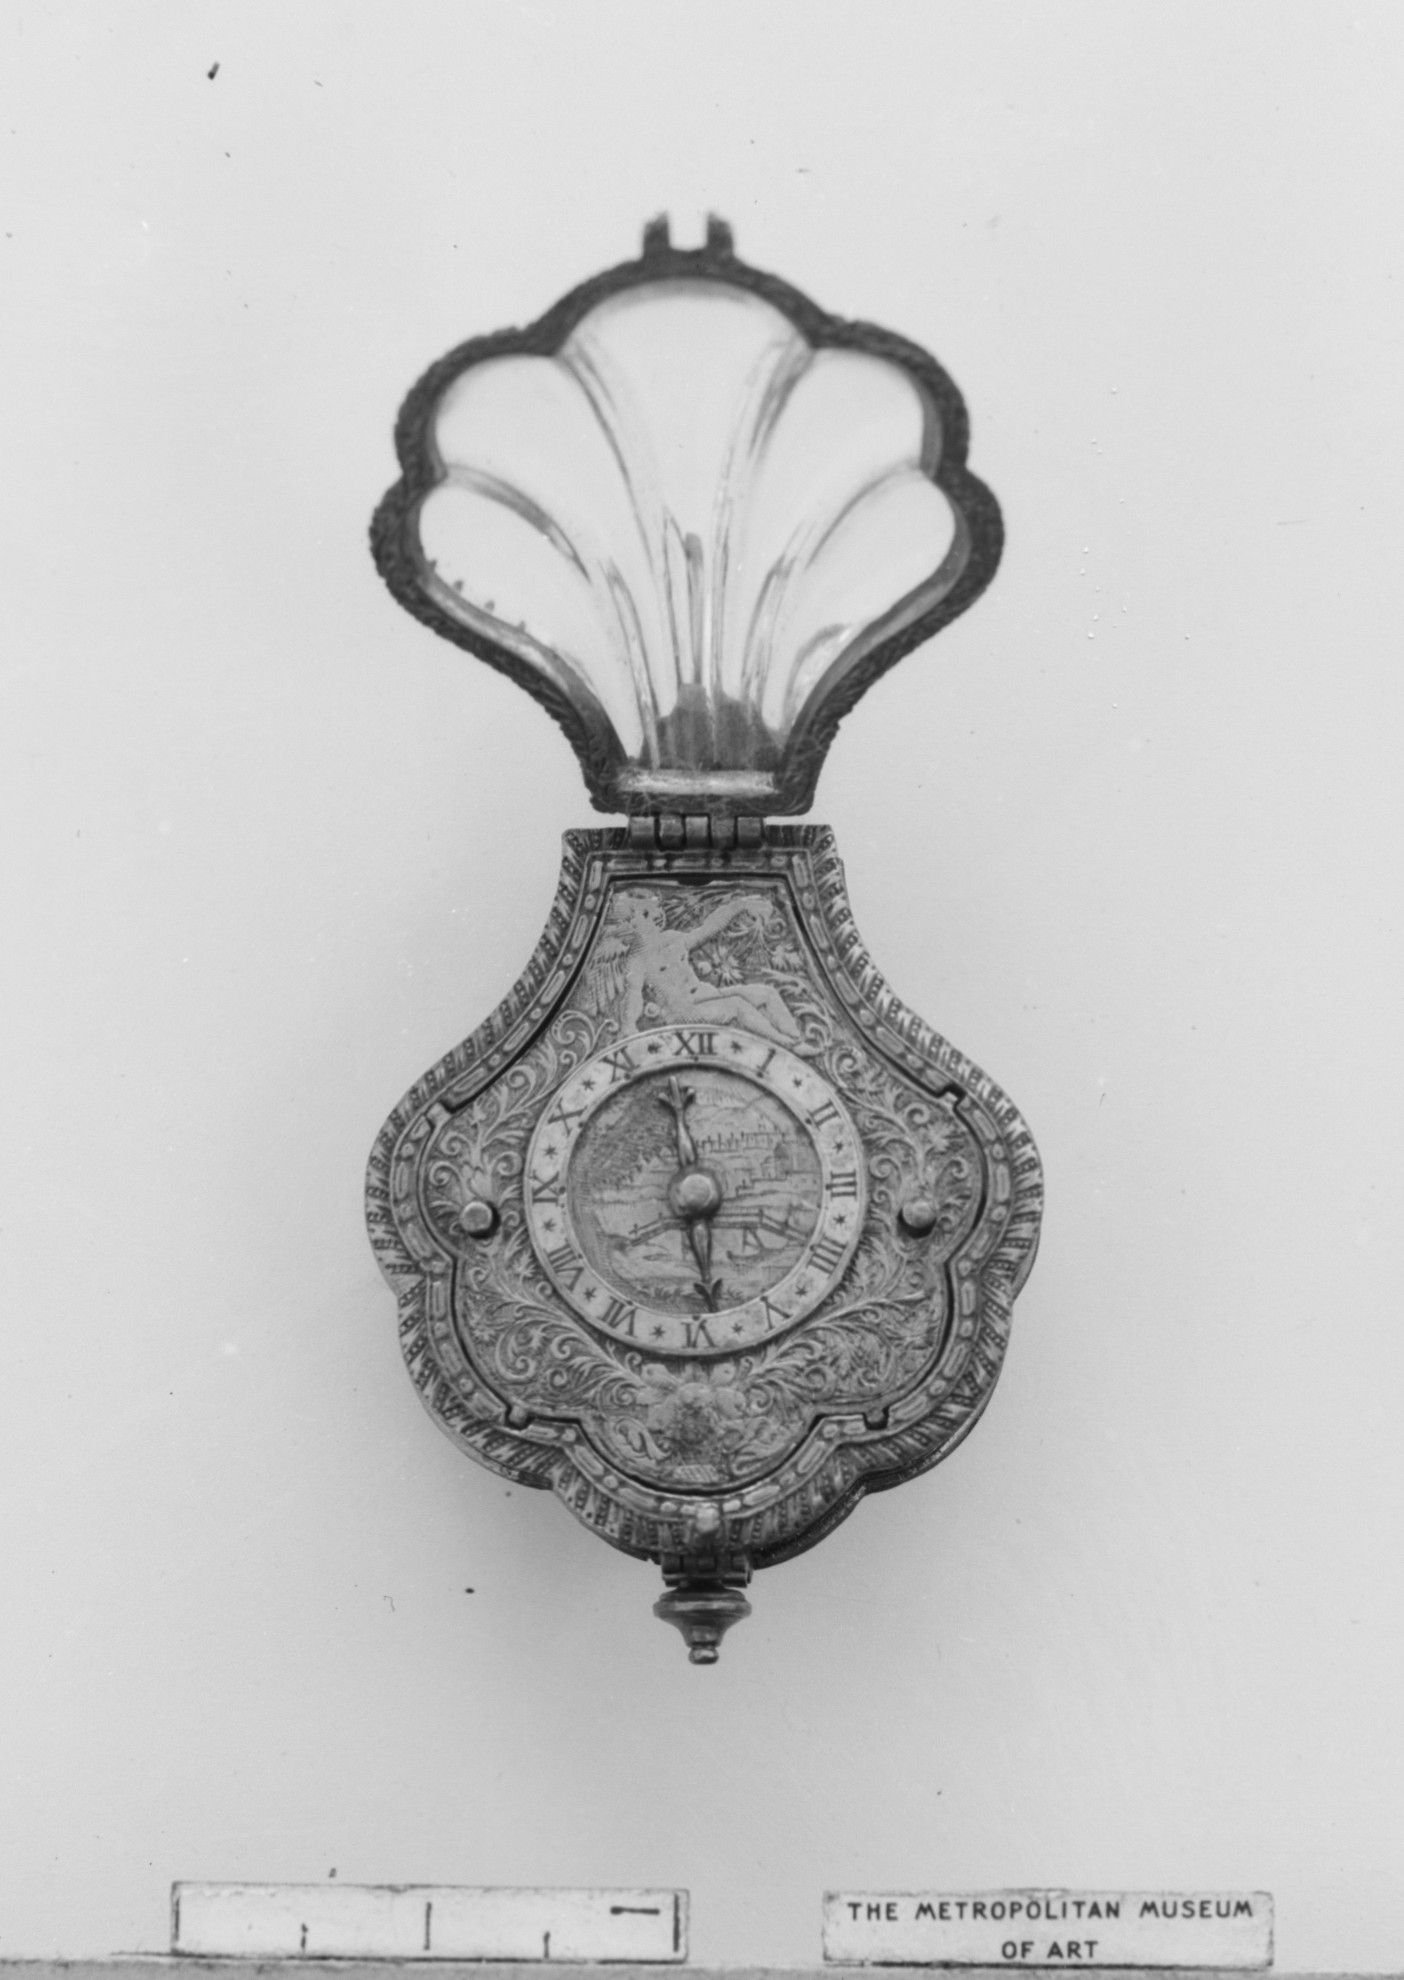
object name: watch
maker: melchior adan (or adam)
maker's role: maker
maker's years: 1605-1615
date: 1501-1700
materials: quartz, silver